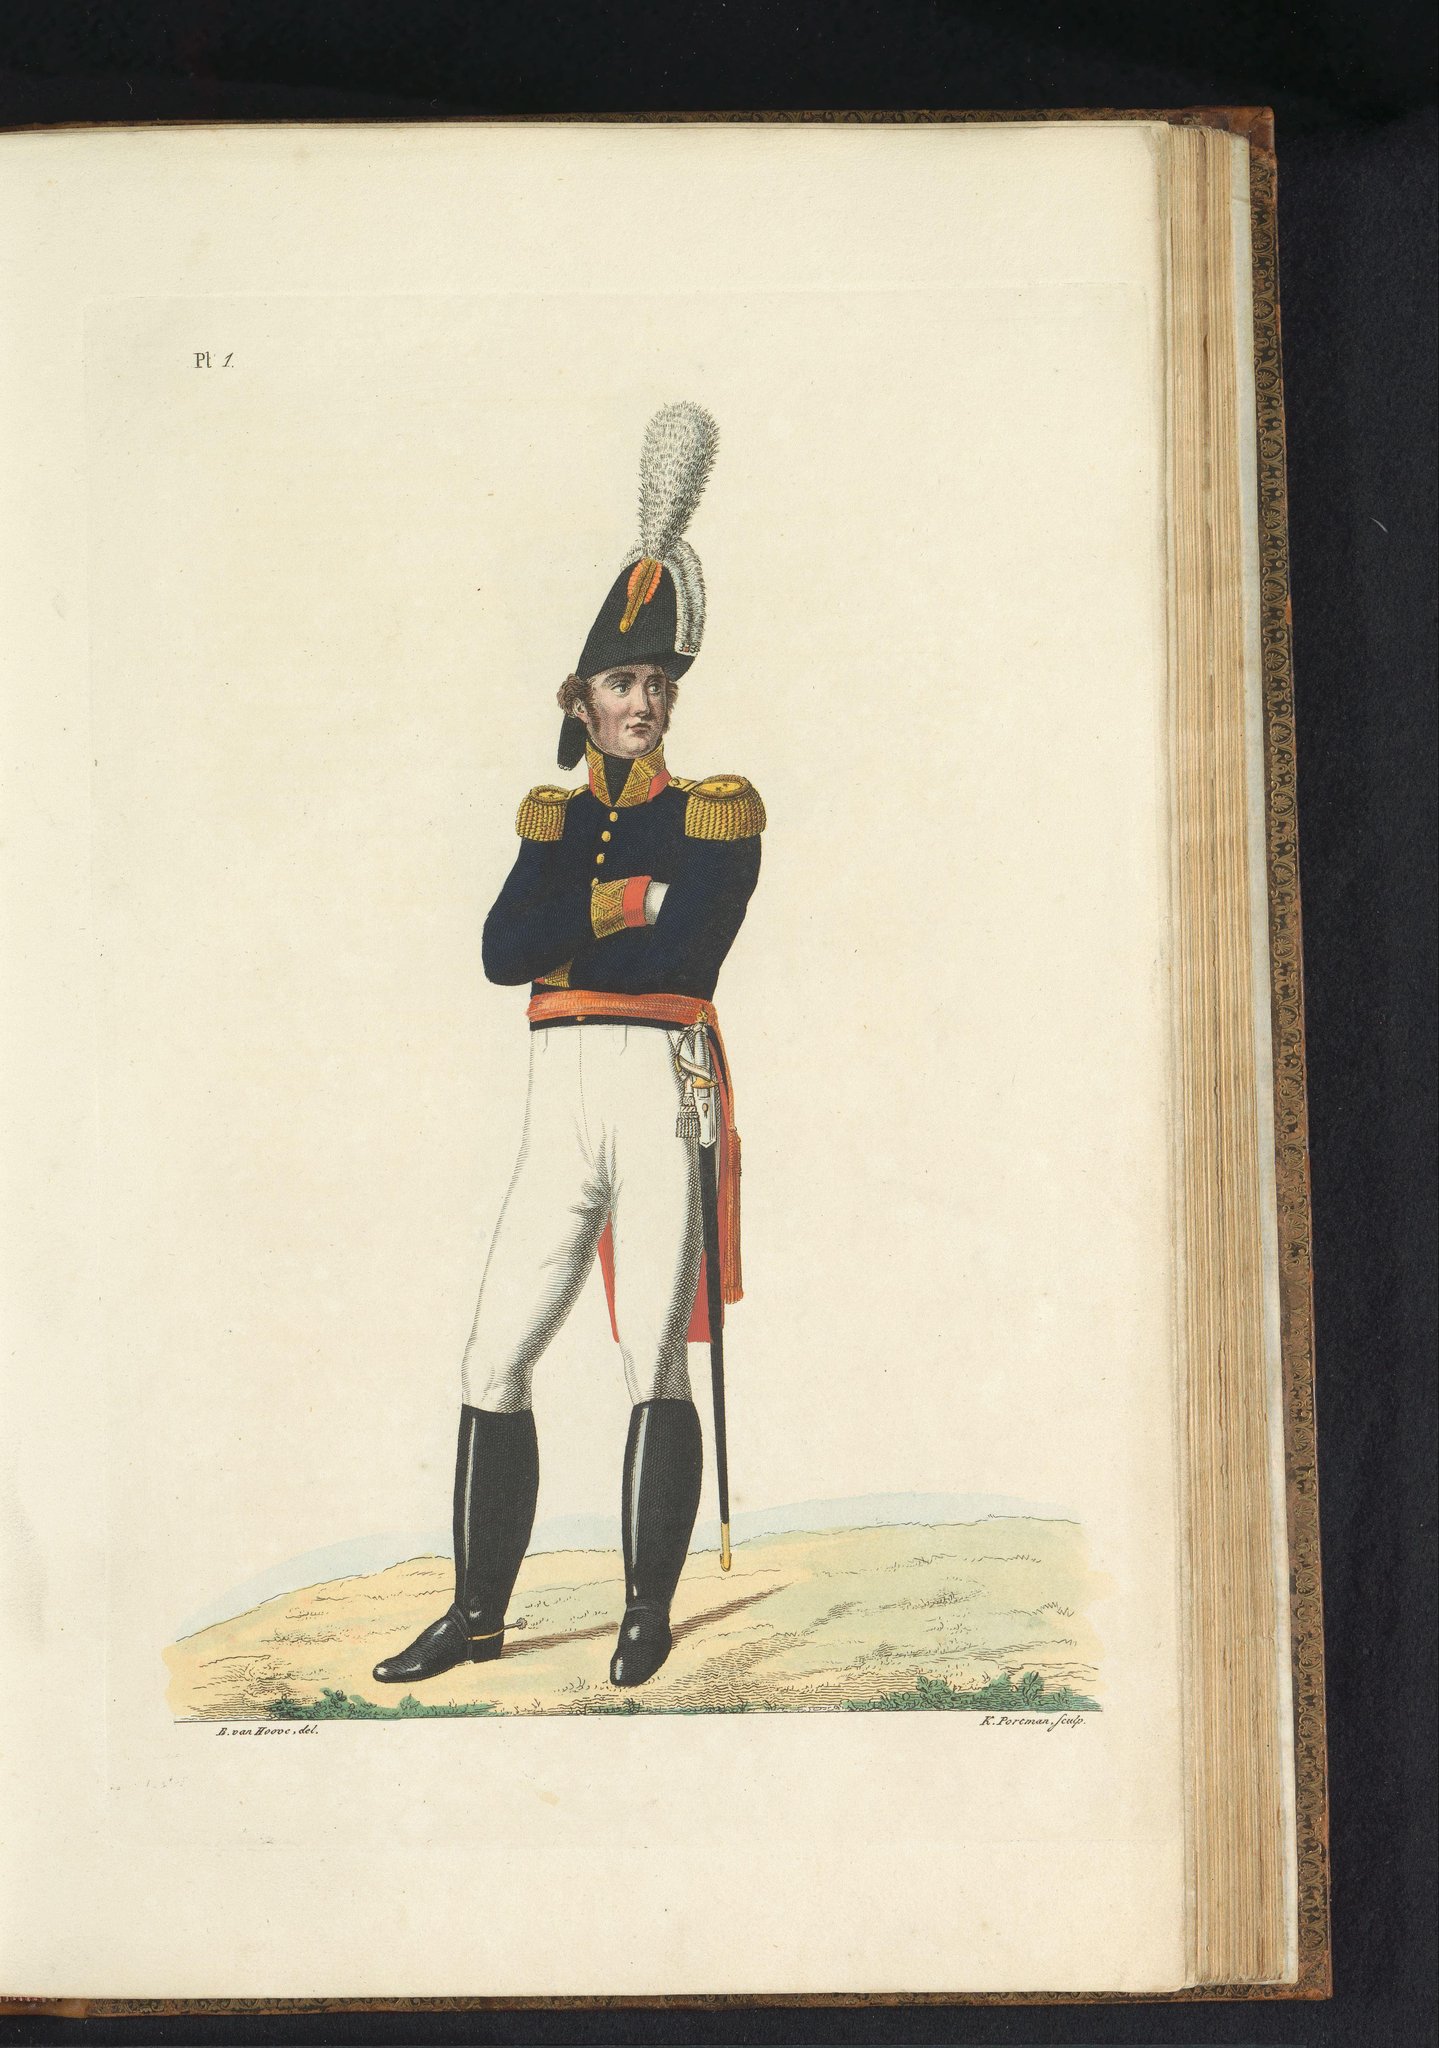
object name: print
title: Generaal-Majoor, in gala tenue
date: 1823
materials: paper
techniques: engraving, etching, hand coloring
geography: the hague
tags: (military) uniforms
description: Een Nederlandse generaal-majoor in gala tenue. Plaat 1. Uniformvoorstelling in 'Beschrijving hoedanig de Koninklijke Nederlandsche troepen' van J.F. Teupken, 1823.